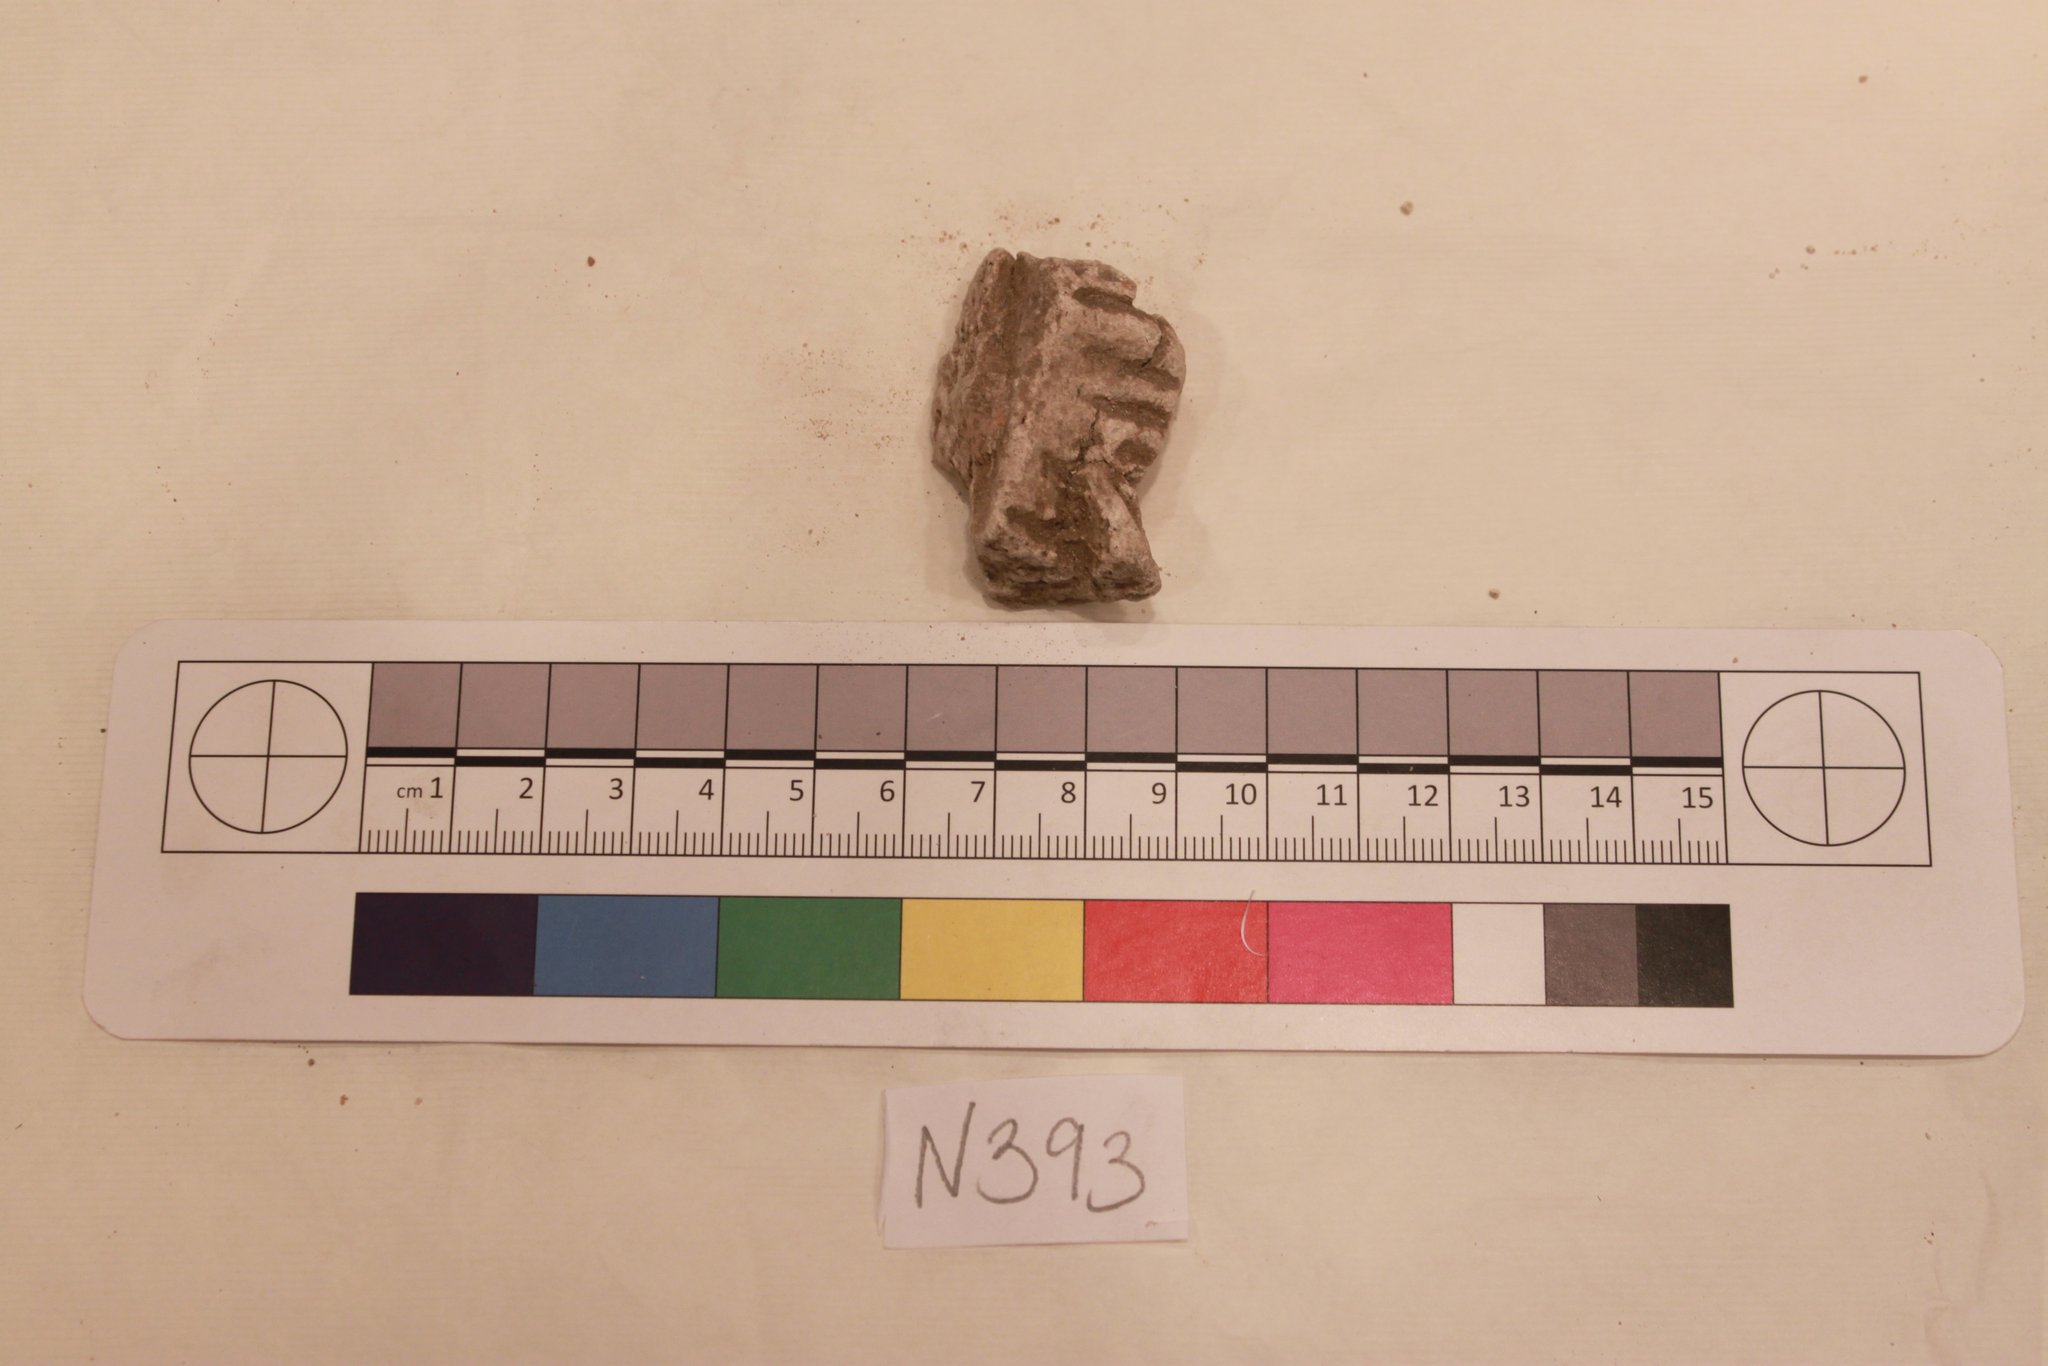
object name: fragment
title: Stucco Fragment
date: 701-1200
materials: plaster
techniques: carving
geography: iran